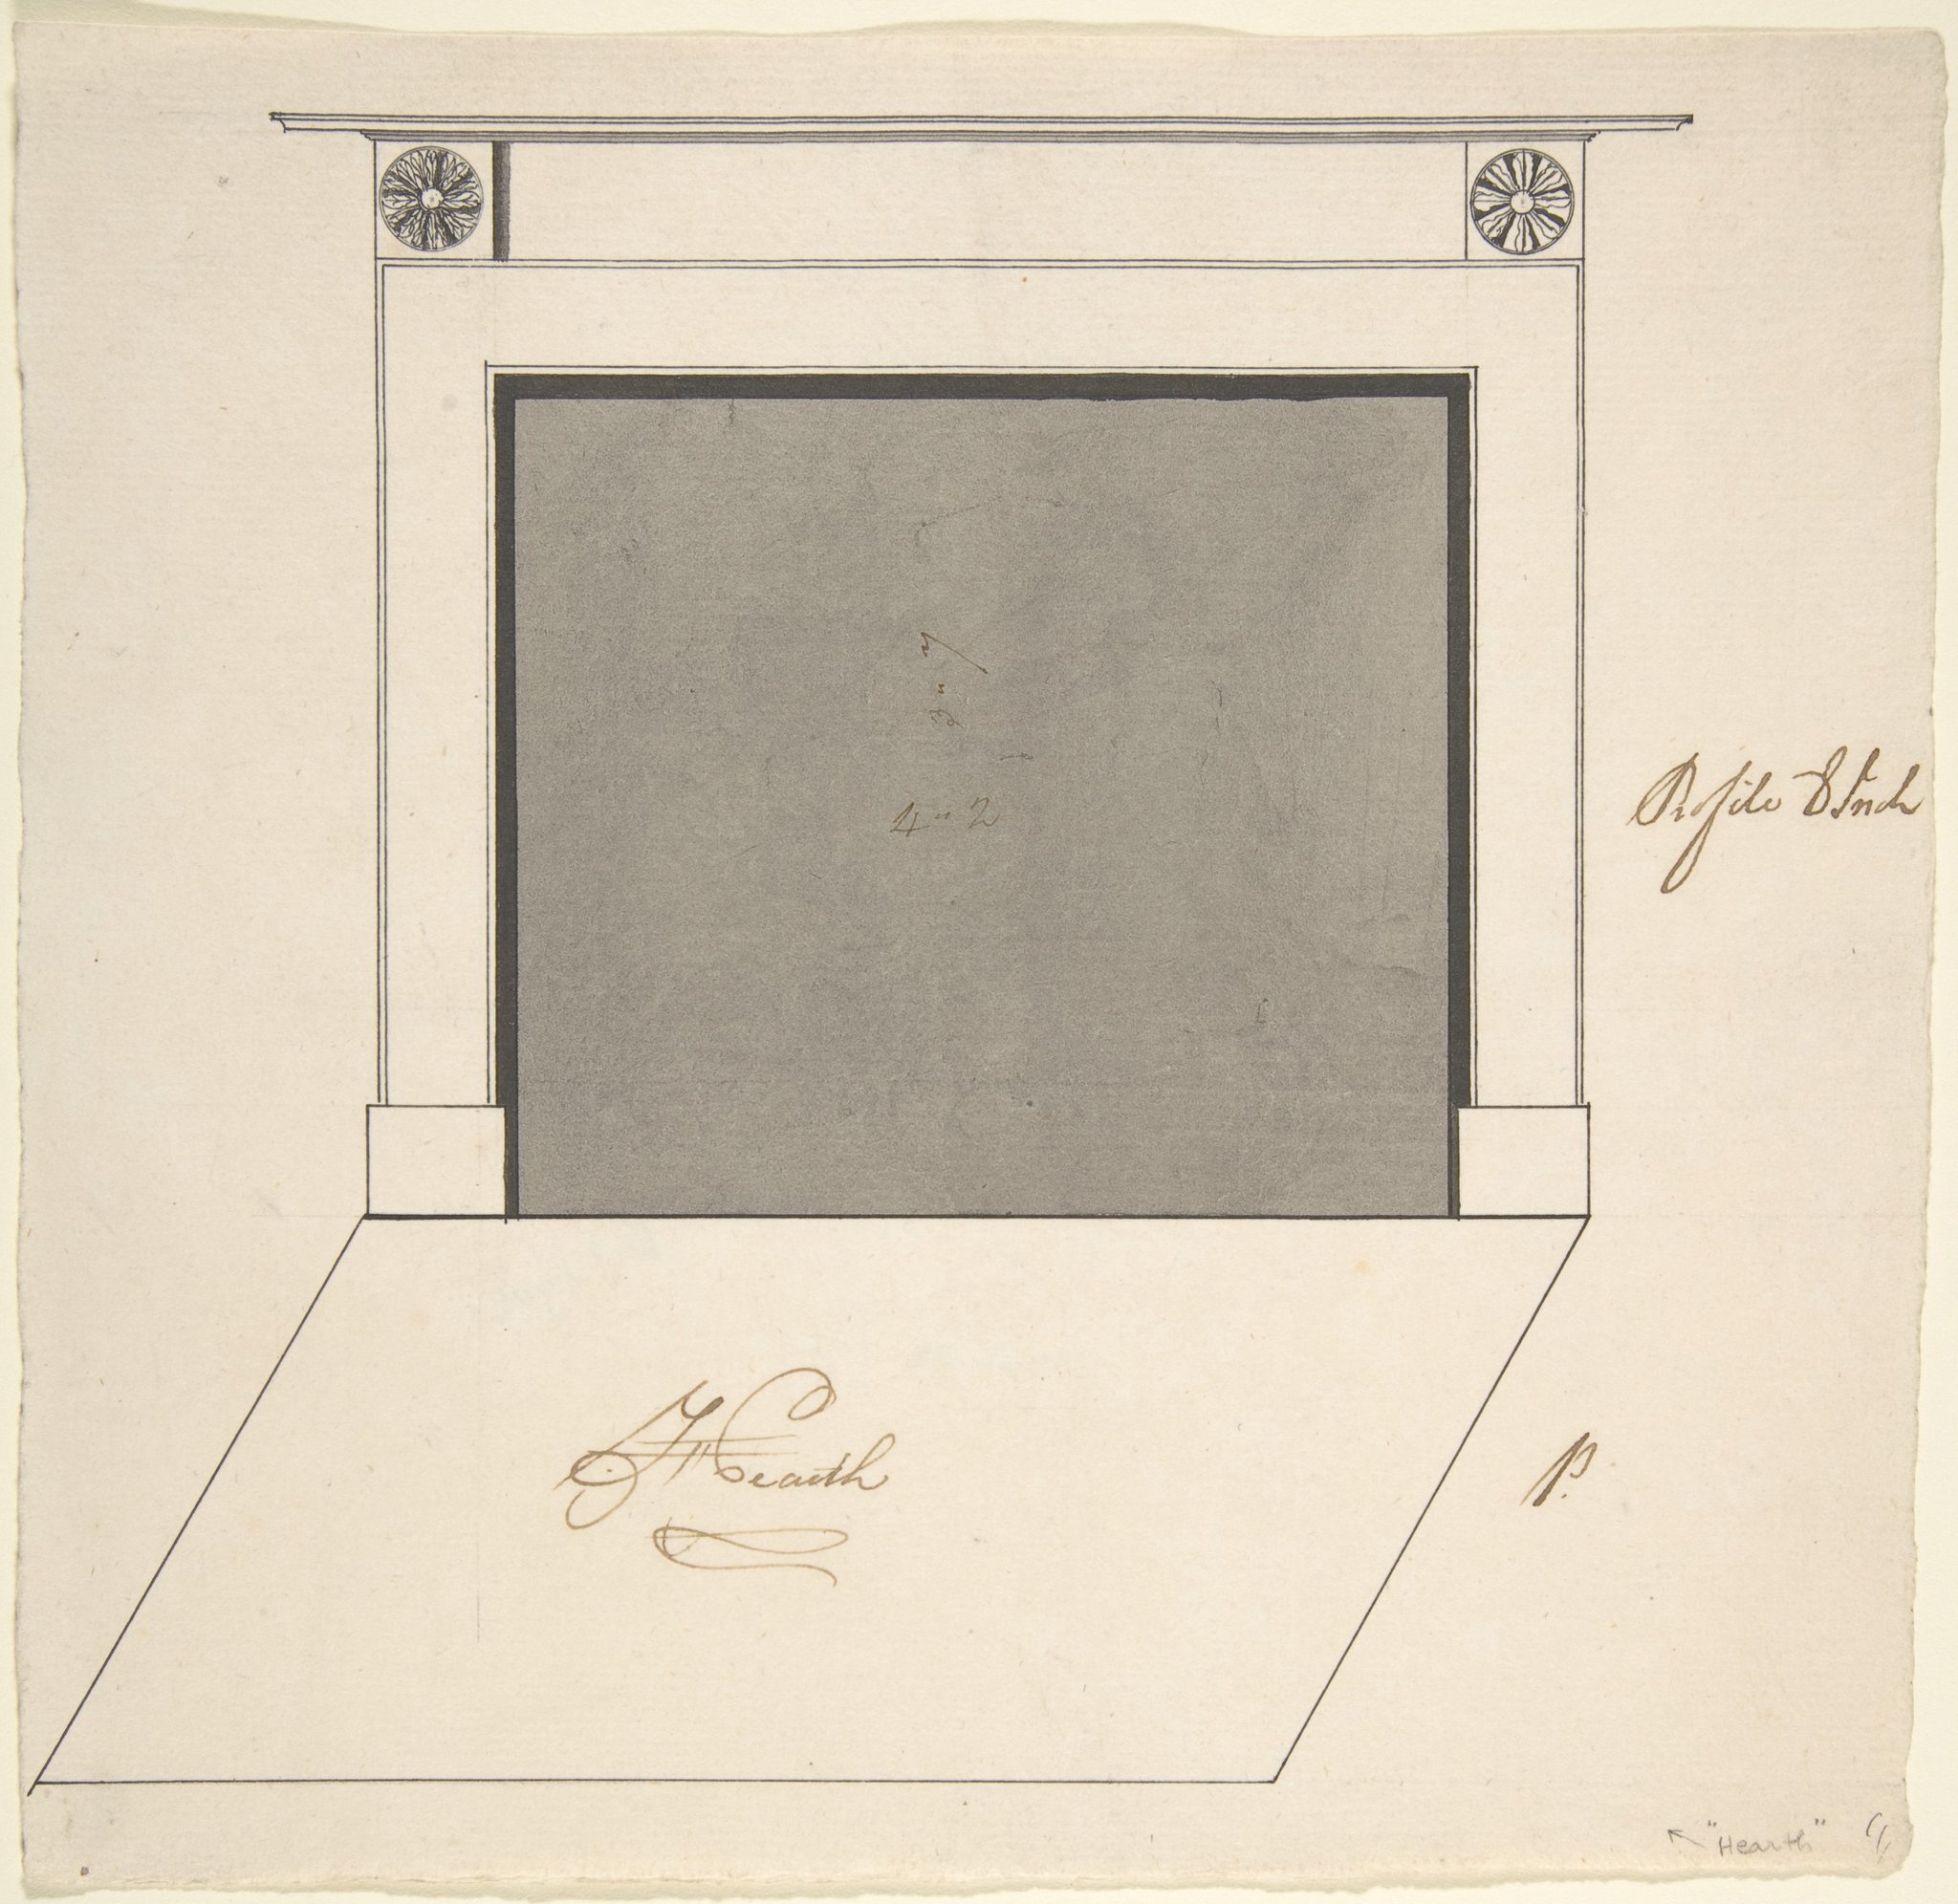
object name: drawing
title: Design for a Chimneypiece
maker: sir william chambers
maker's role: artist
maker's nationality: british, born sweden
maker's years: 1723-1796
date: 1740-1796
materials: ink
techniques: brush, pen, wash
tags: fireplaces